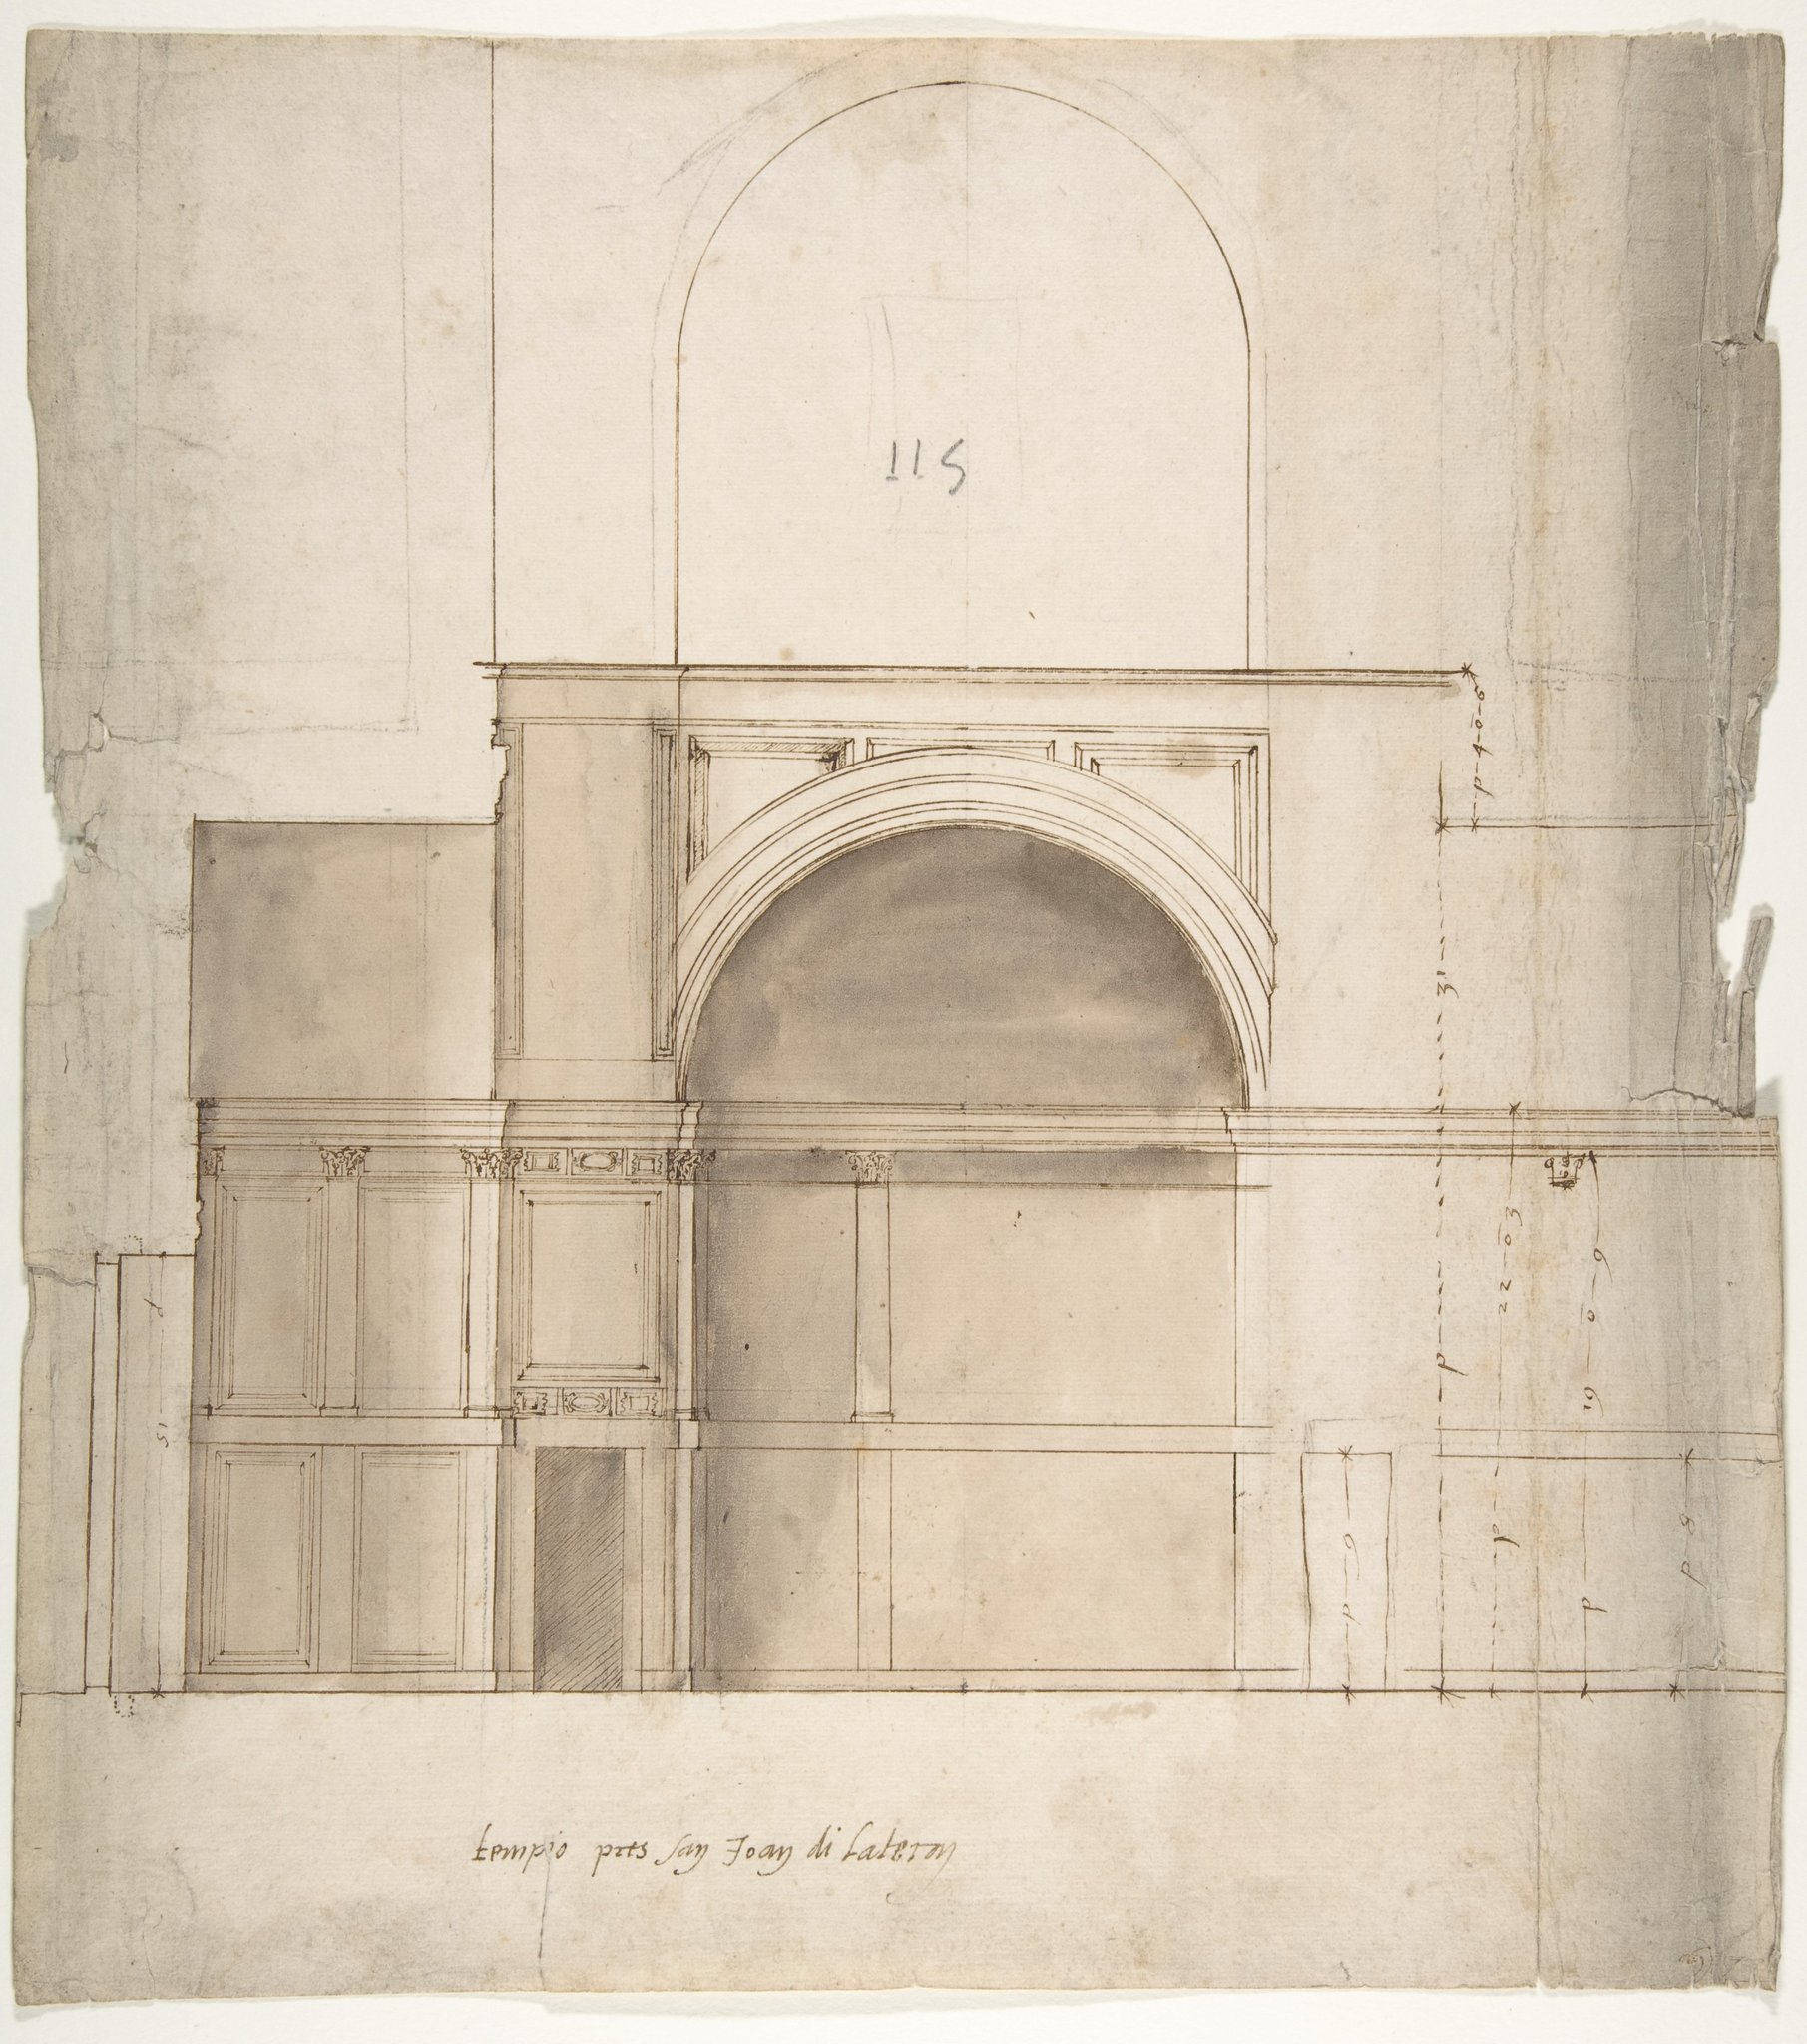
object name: collection ornament architecture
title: S. Giovanni Laterno, Oratorio della Santa Croce, section (recto) blank (verso)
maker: anonymous, french, 16th century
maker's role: draftsman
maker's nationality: french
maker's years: 1500-1600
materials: chalk, ink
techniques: incising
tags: architecture,arches